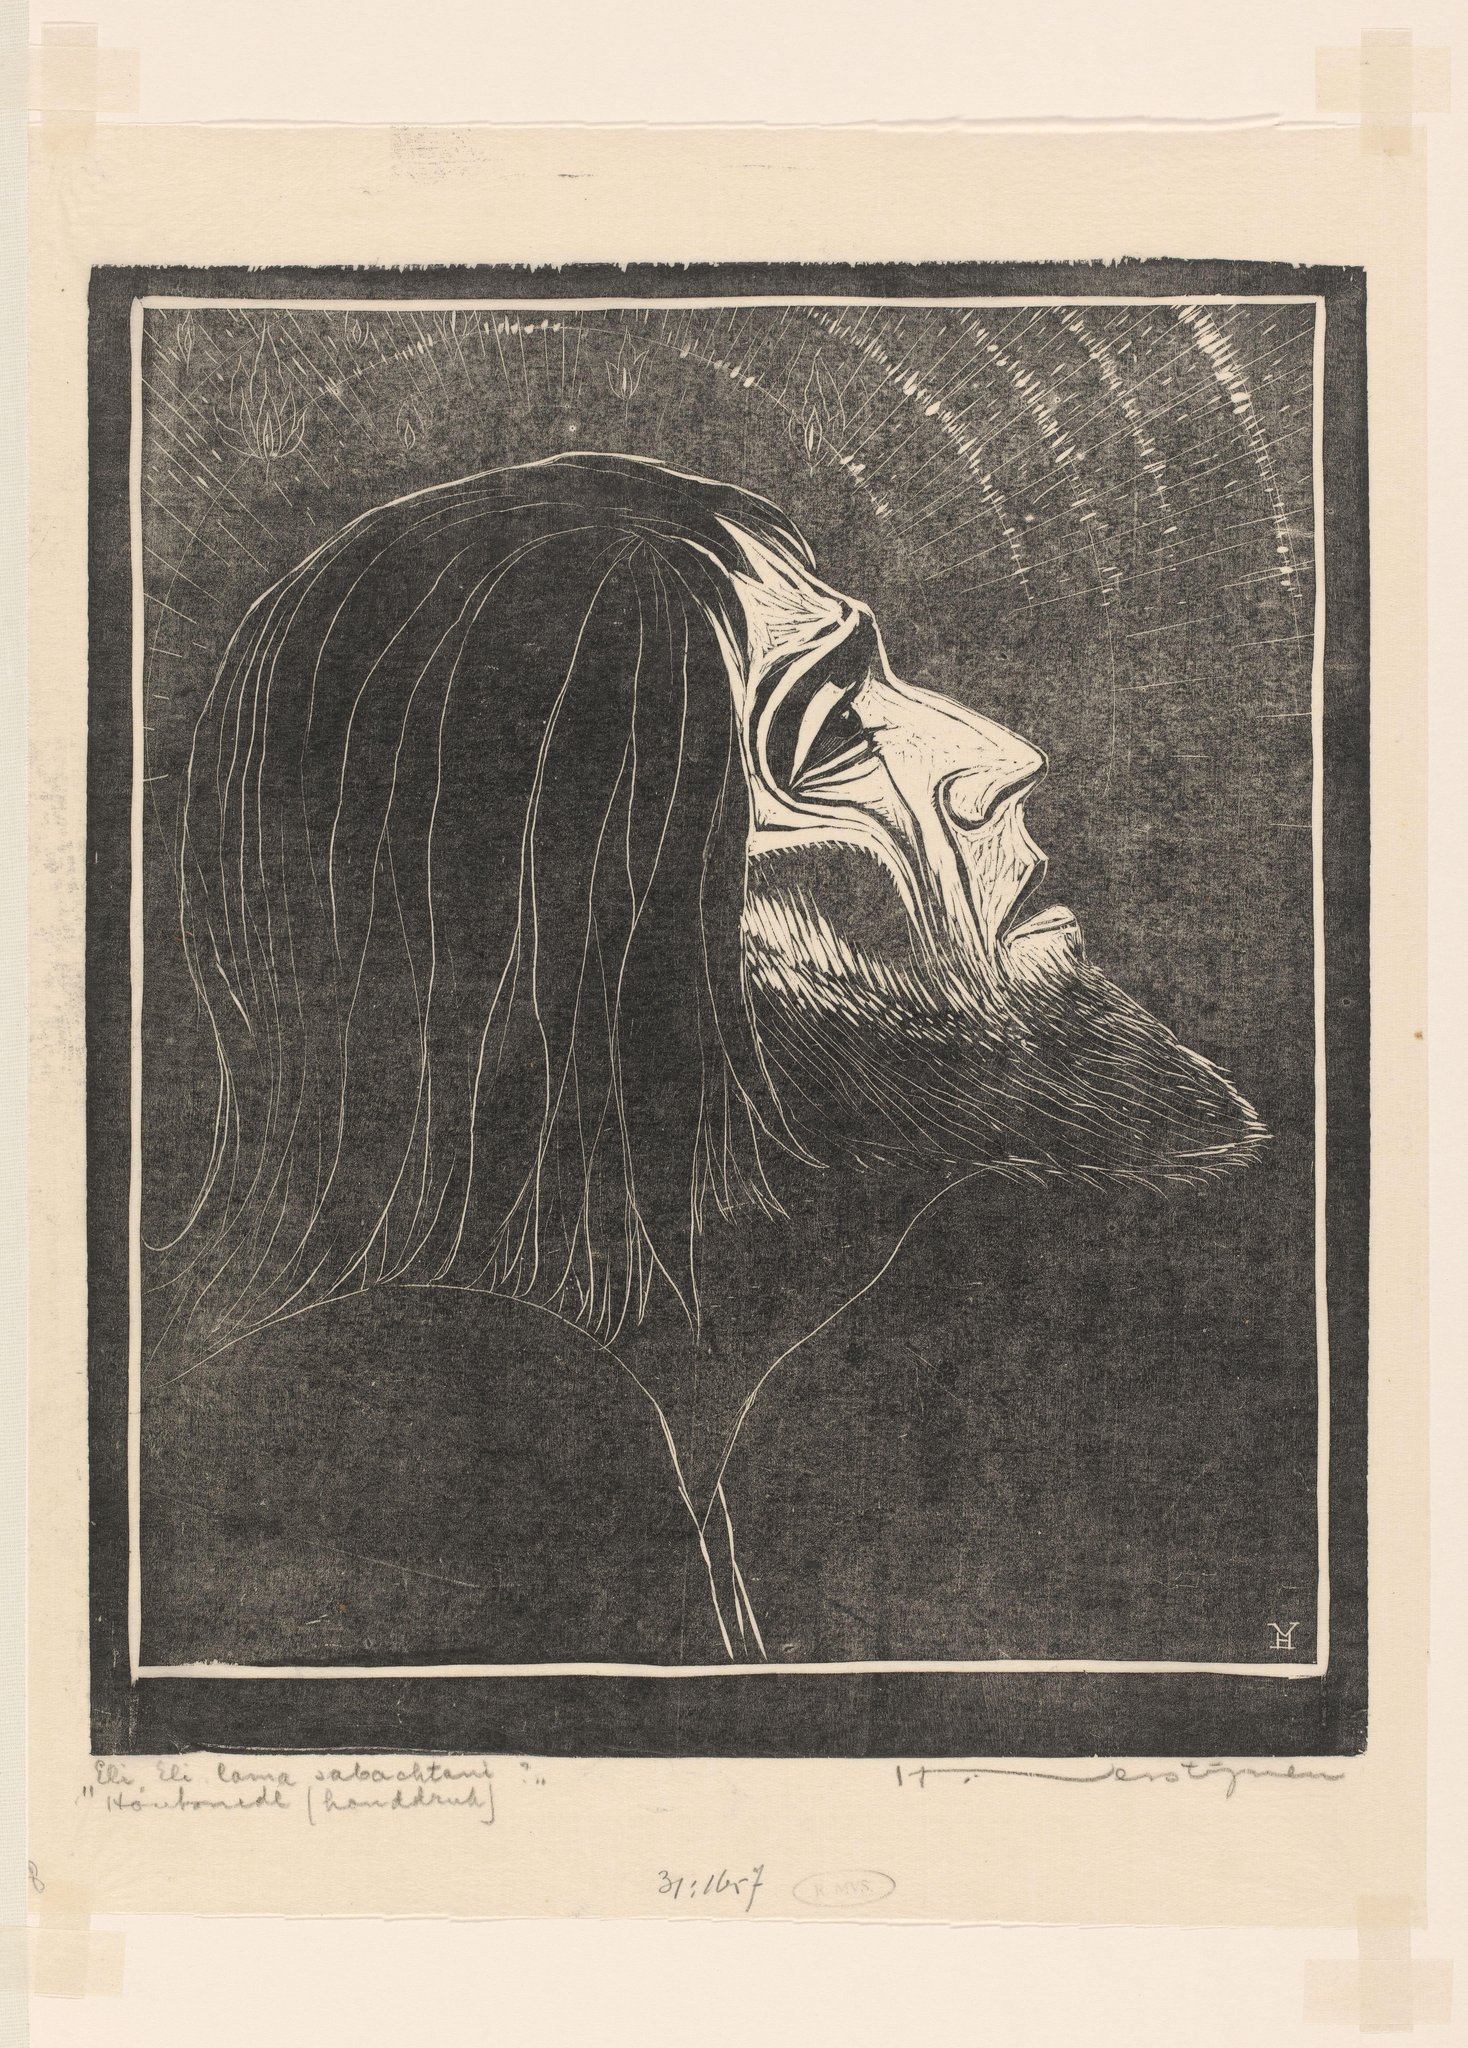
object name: print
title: Eli, Eli lama sabachtani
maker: henri verstijnen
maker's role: draughtsman, print maker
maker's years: 1882-1940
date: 1892-1931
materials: paper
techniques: woodcut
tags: christ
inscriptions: collector's mark: Lugt 2228